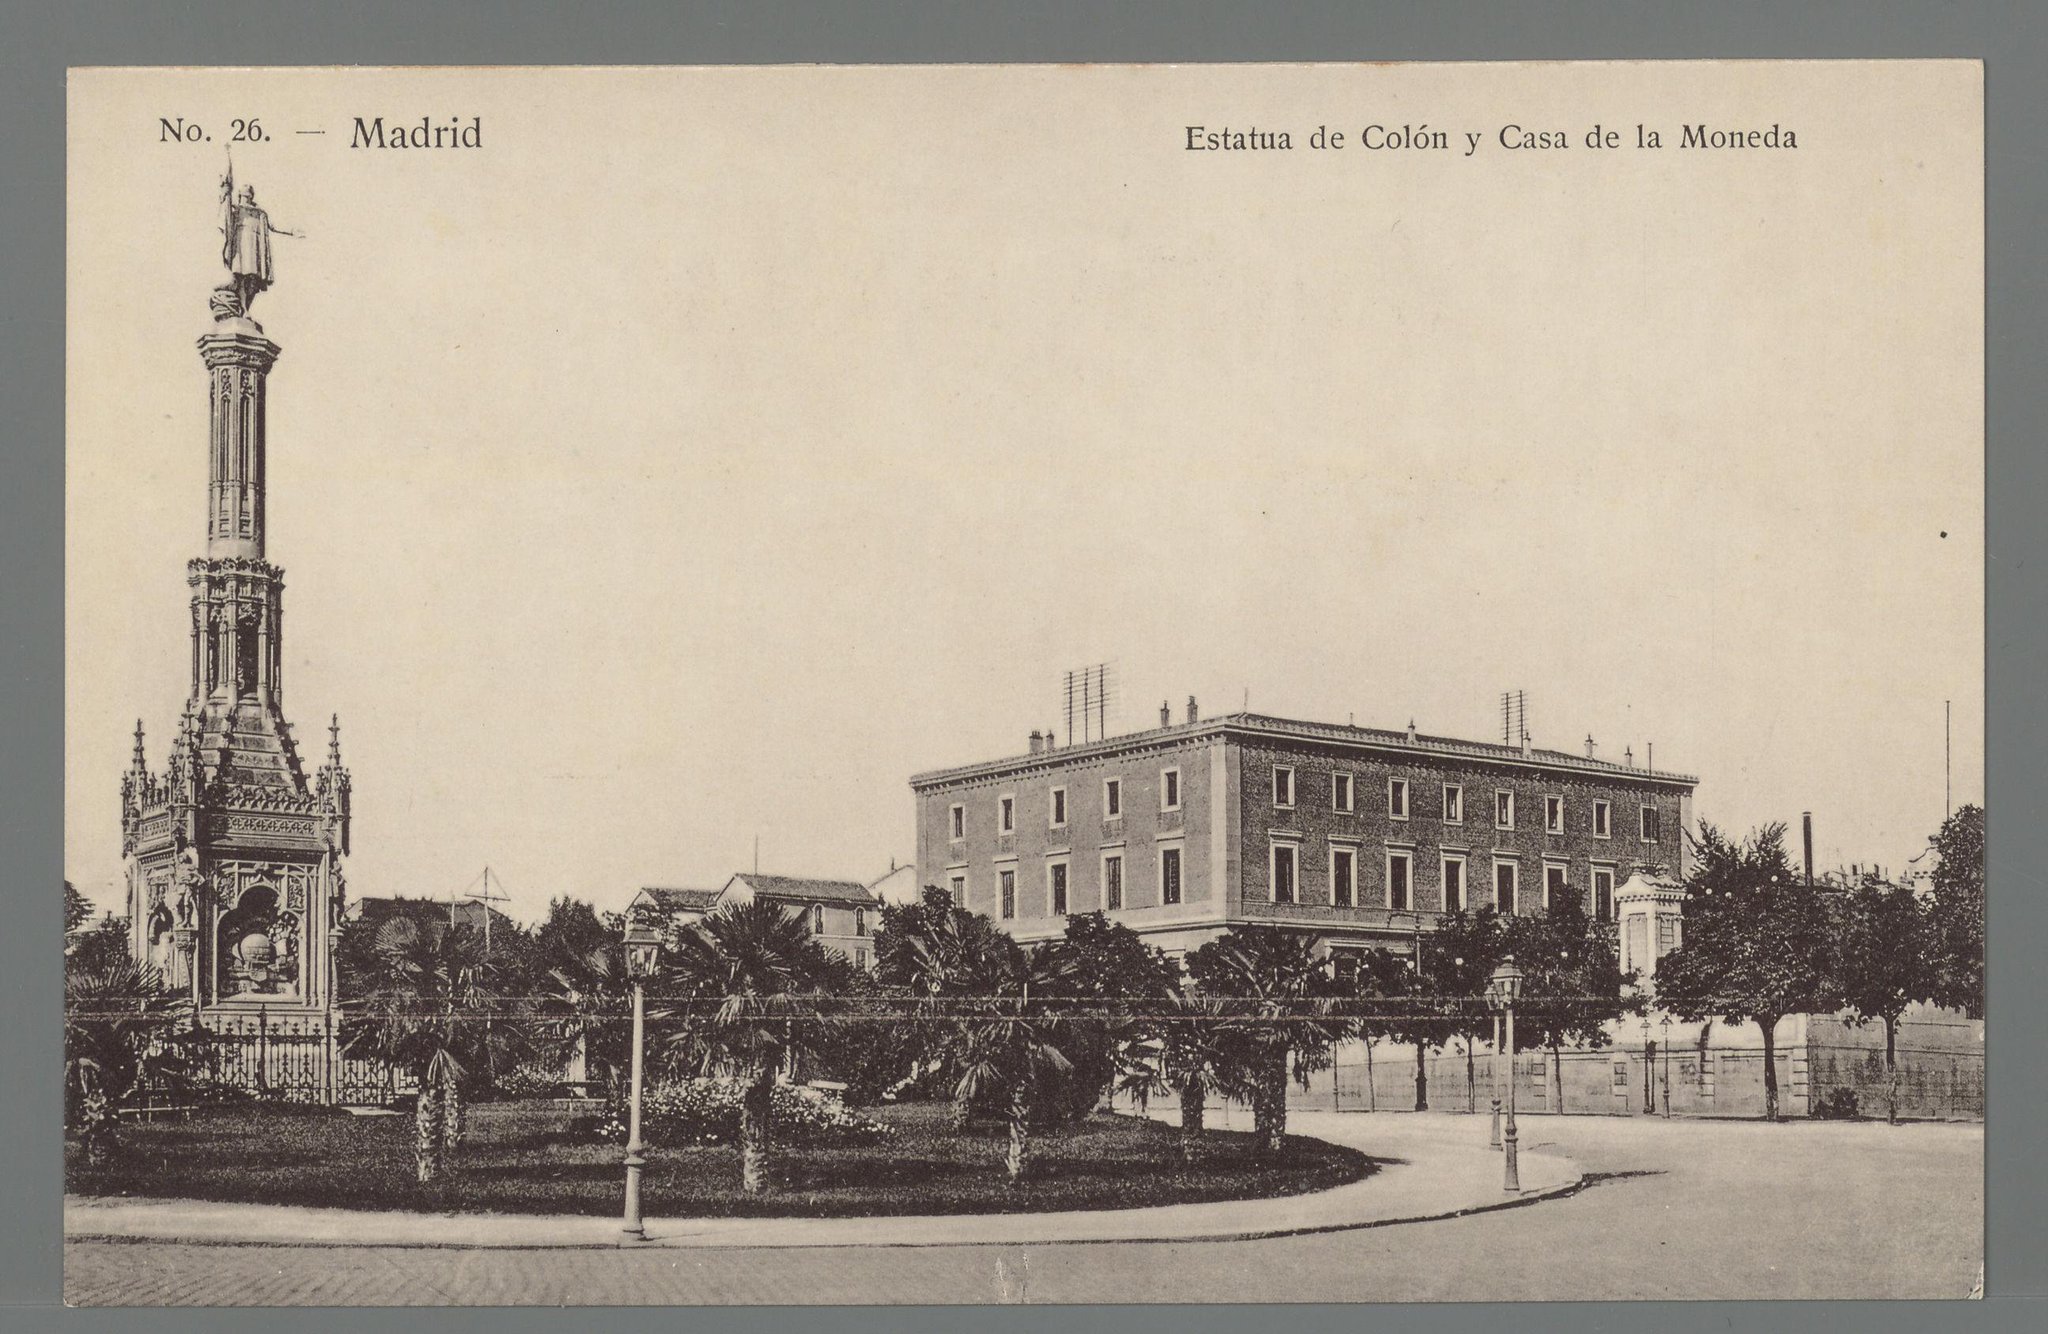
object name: ansichtkaart, prentbriefkaart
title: Madrid. Estatua de Colón y Casa de la Moneda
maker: Anonymous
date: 1906-1930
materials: cardboard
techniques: photograph, writing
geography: madrid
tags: square, place, circus, etc., monument, statue, villa